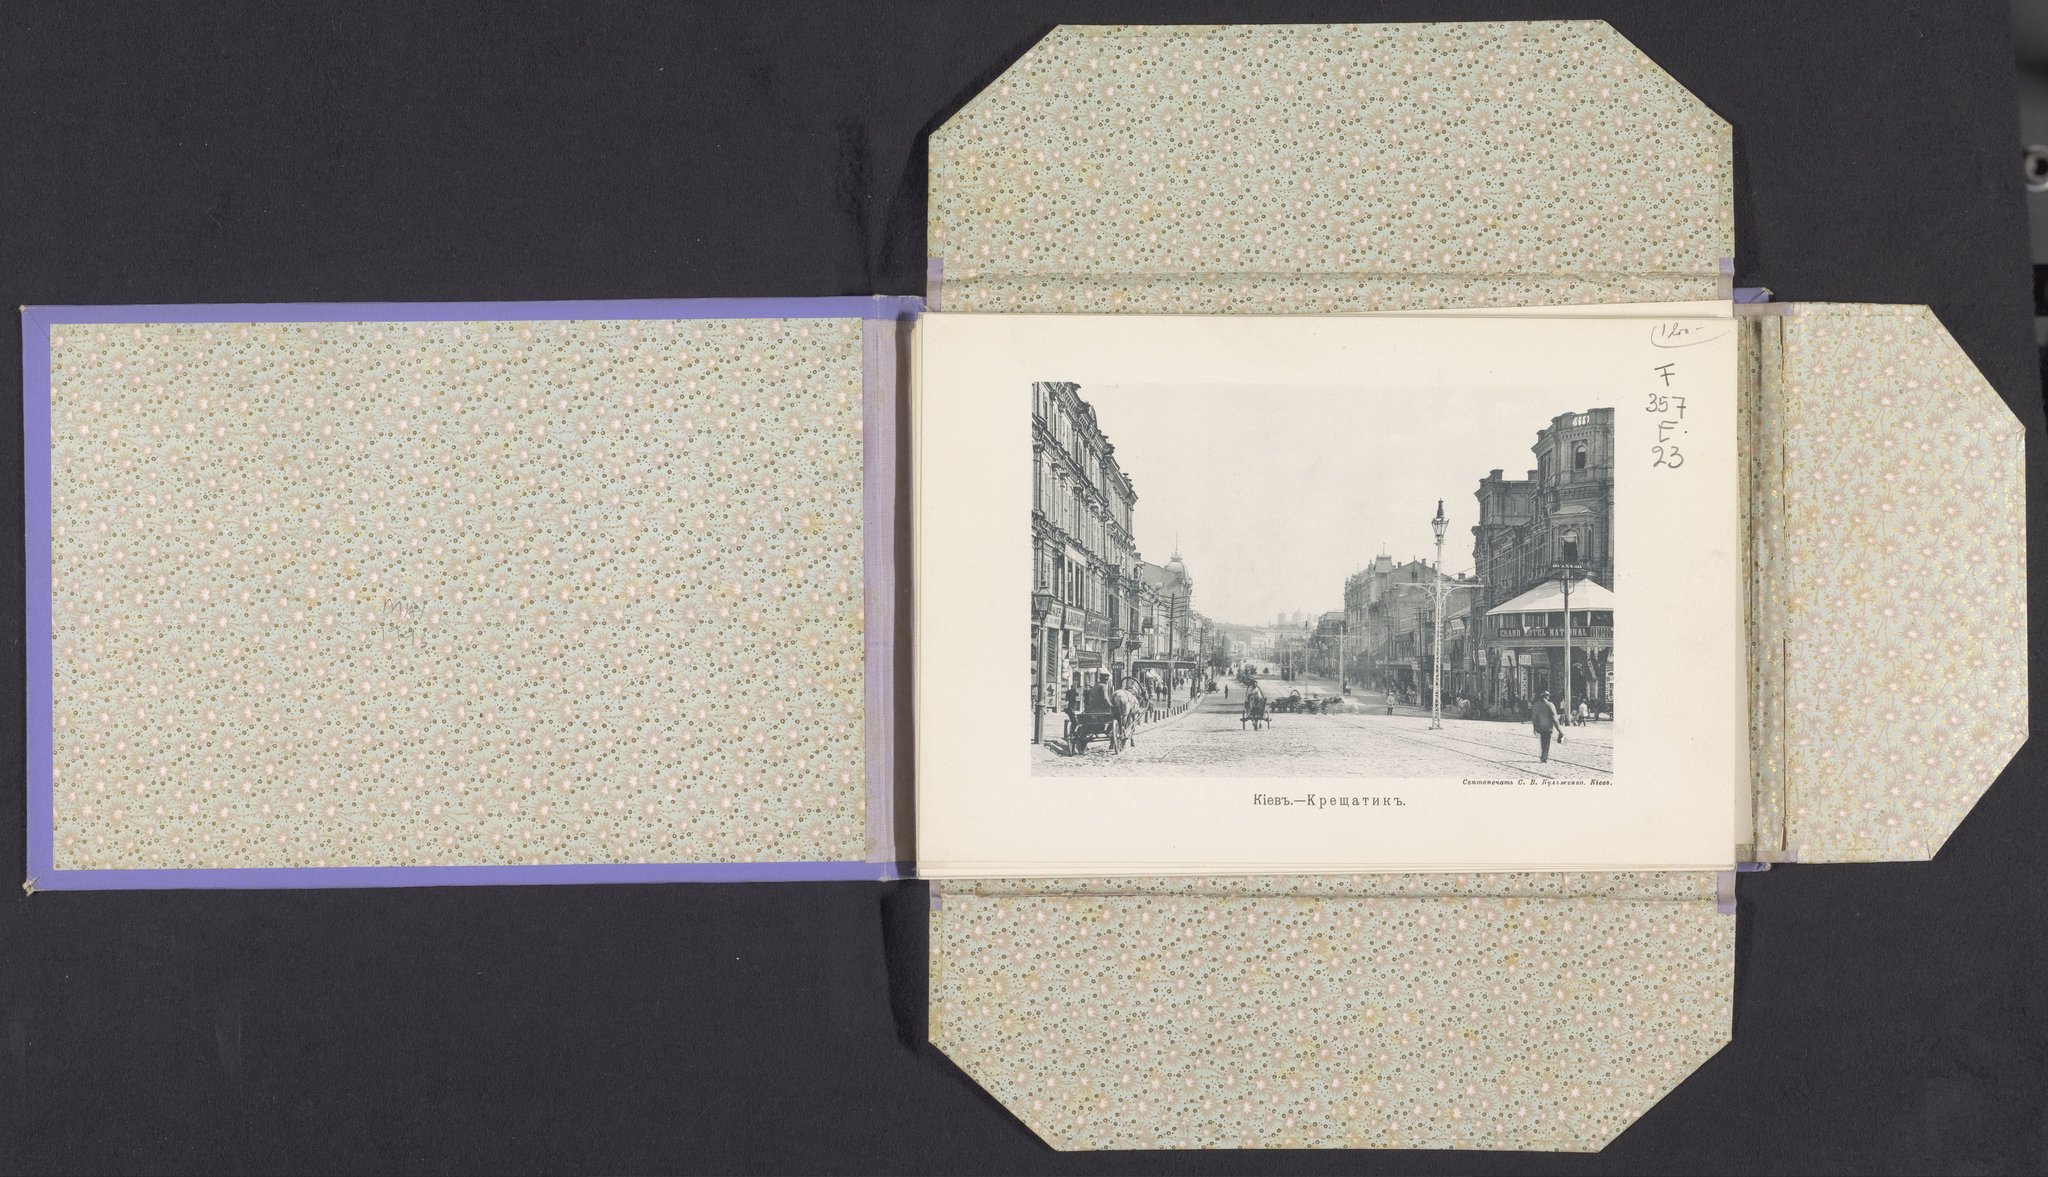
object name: photomechanical print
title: Kiebъ.-Kpeщatиkъ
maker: Anonymous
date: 1886-1896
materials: paper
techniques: photograph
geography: kyiv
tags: façade (of house or building), street